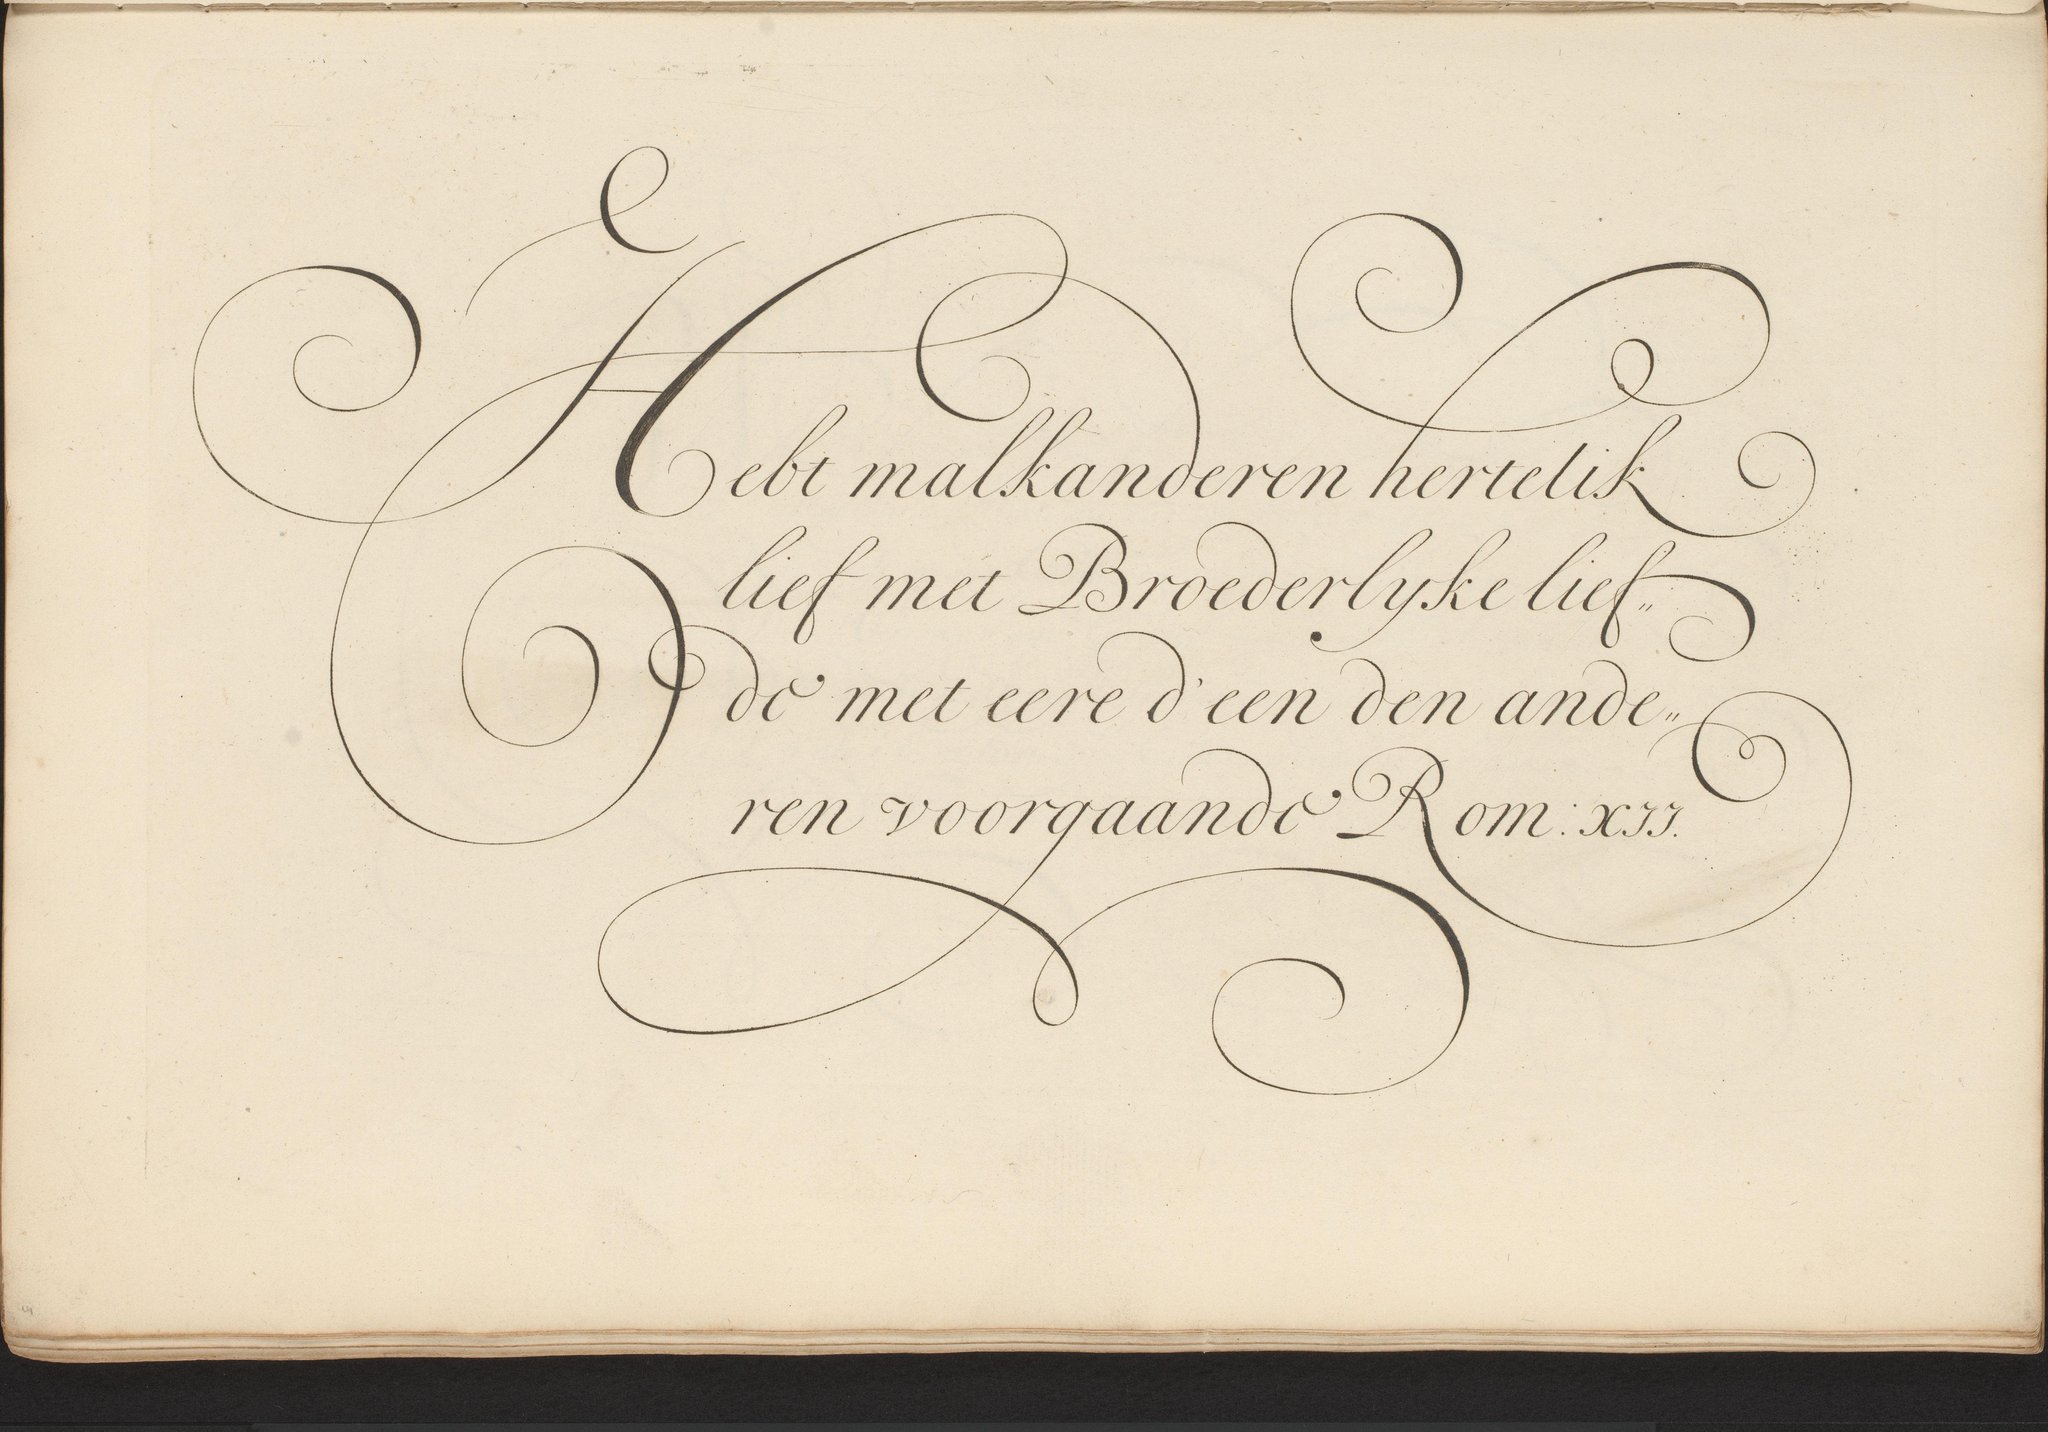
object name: album leaf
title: Schrijfvoorbeeld: Hebt malkanderen hertelik (...)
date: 1660-1751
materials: paper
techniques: engraving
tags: calligraphy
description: Schrijfvoorbeeld met vier regels tekst in het Nederlands: Hebt malkanderen hertelik ... De prent maakt deel uit van een album